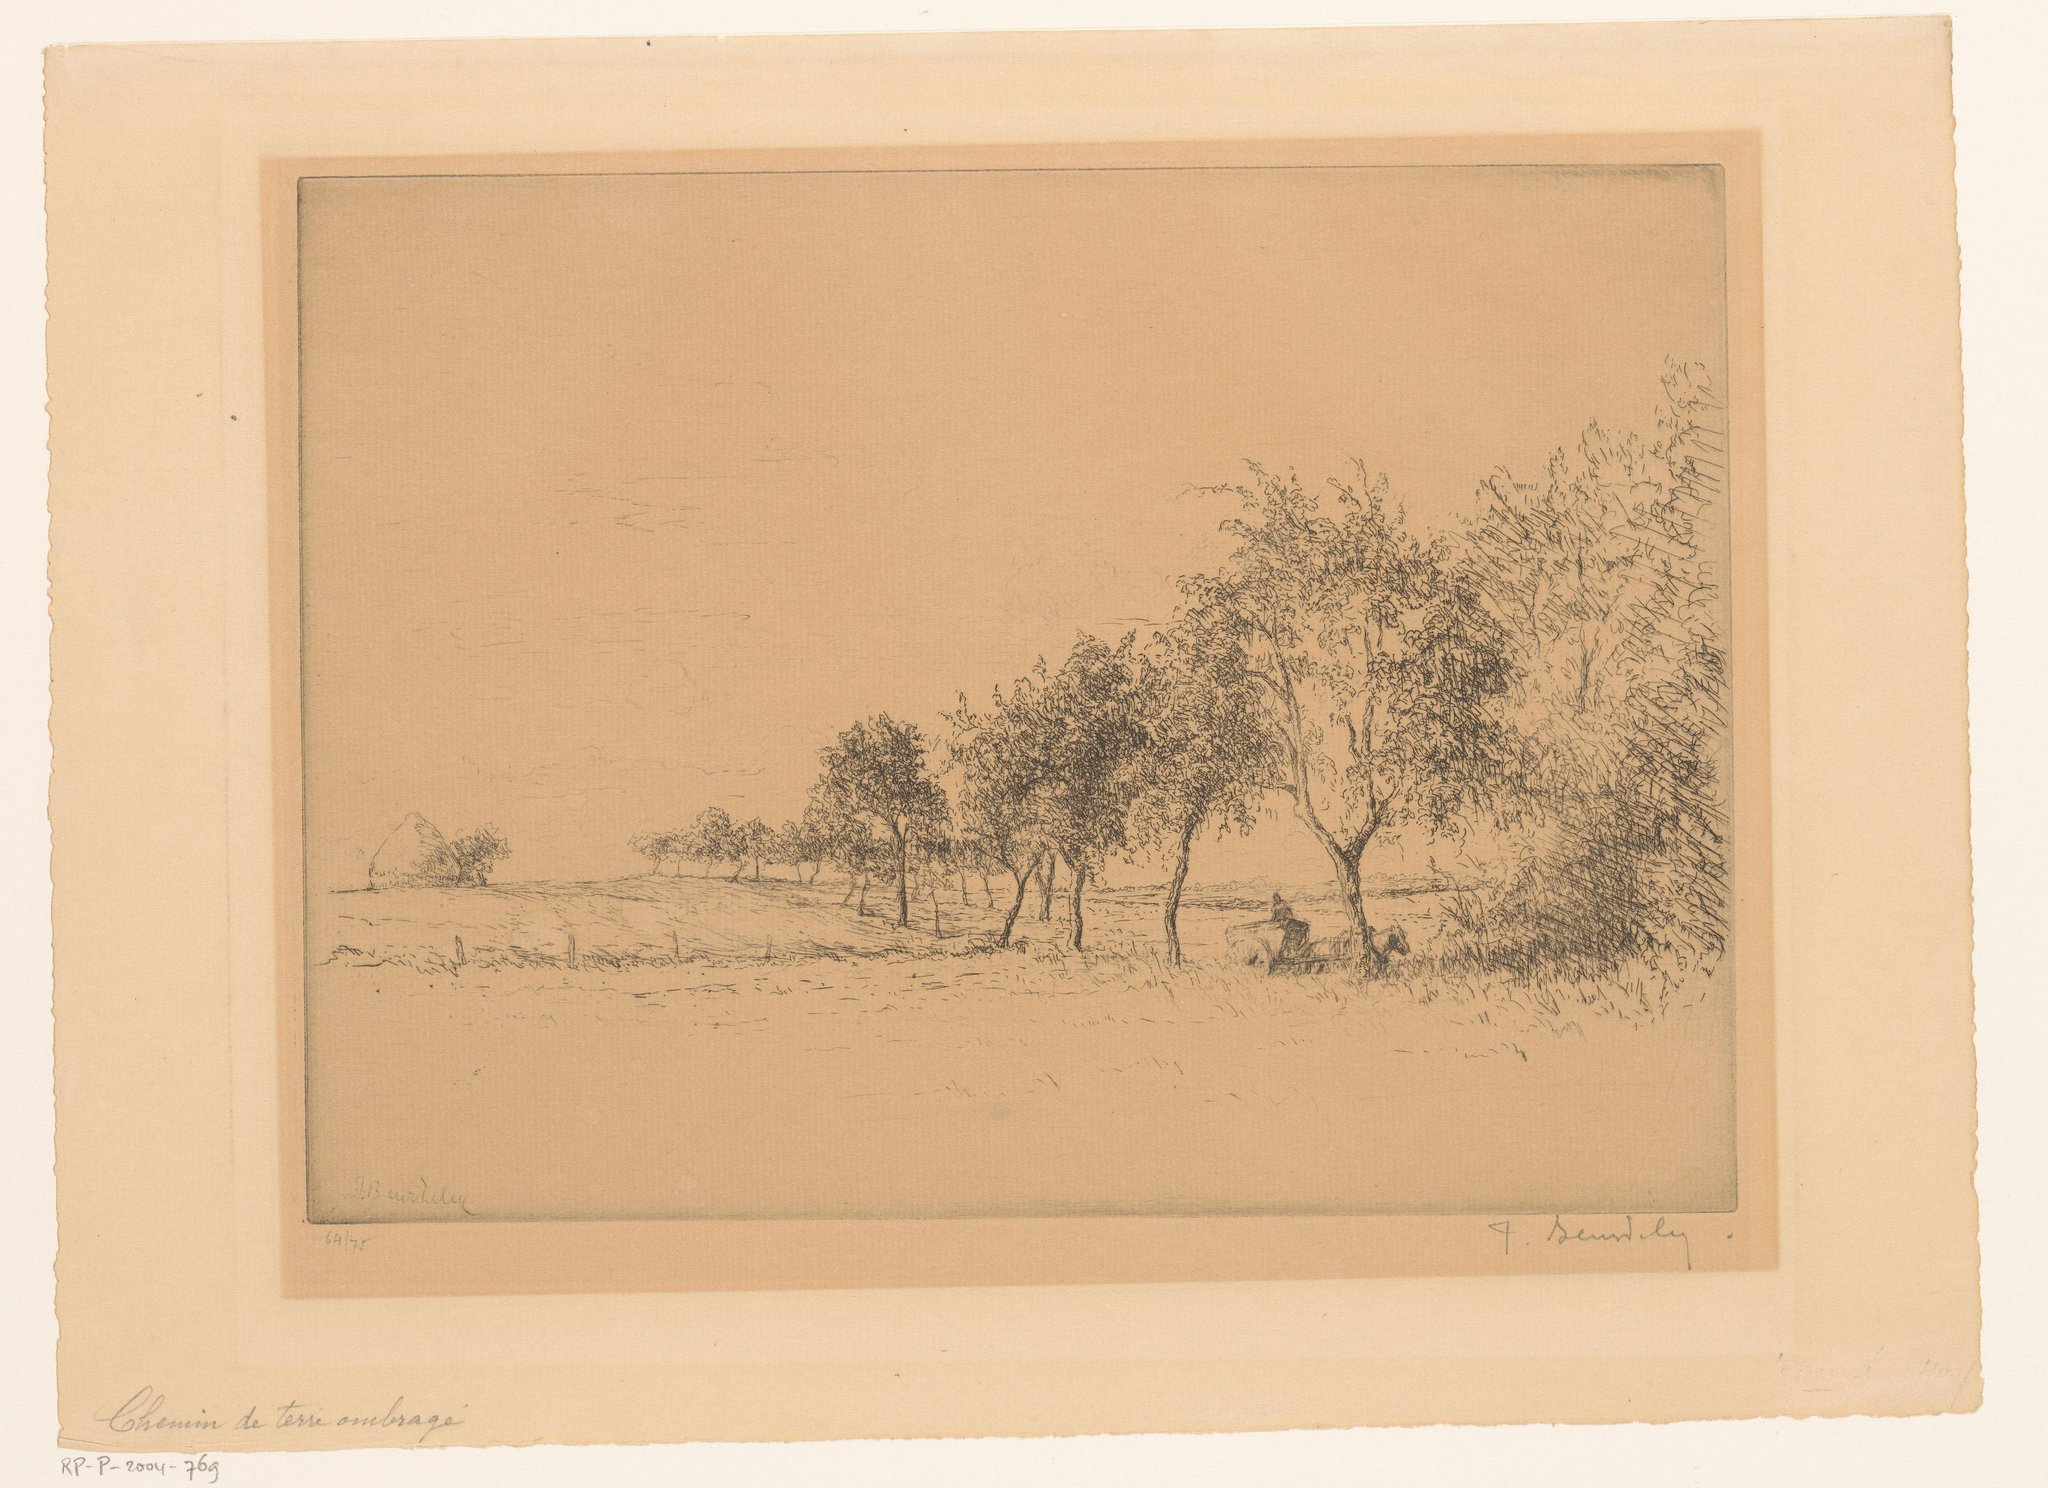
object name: print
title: Chemin de terre ombragé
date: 1923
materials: paper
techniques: etching, intaglio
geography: paris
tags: farmers, hay-stack, plain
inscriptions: collector's mark: Lugt 2228, check stamp: Lugt 2254